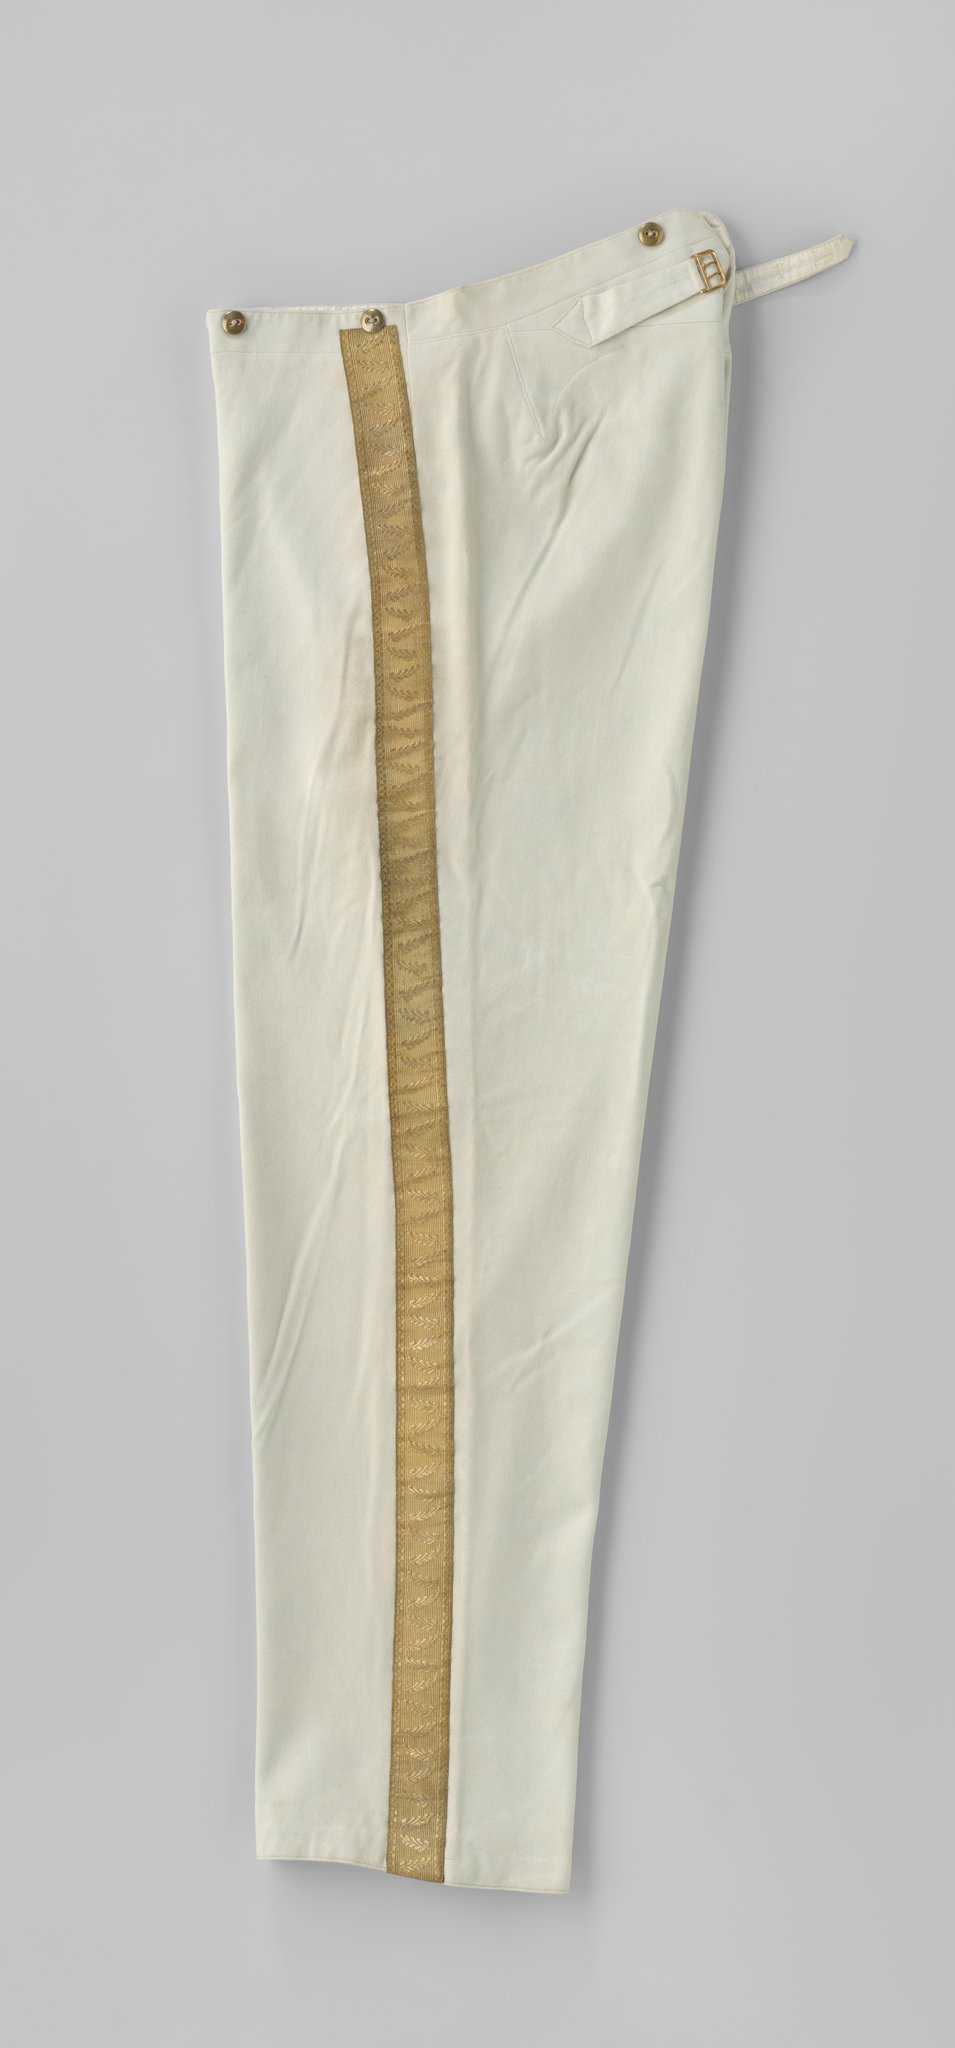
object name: clothing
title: Lange broek van wit laken met koperen knopen, taille met V-vormige split en bandjes met gouden gesp; langs de pijpen afgezet met goudgalon met bladslinger.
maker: Anonymous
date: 1800-1900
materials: textile, copper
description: Lange broek van wit laken. Aan beide zijden langs de pijpen afgezet met goud galon. Koperen knopen.